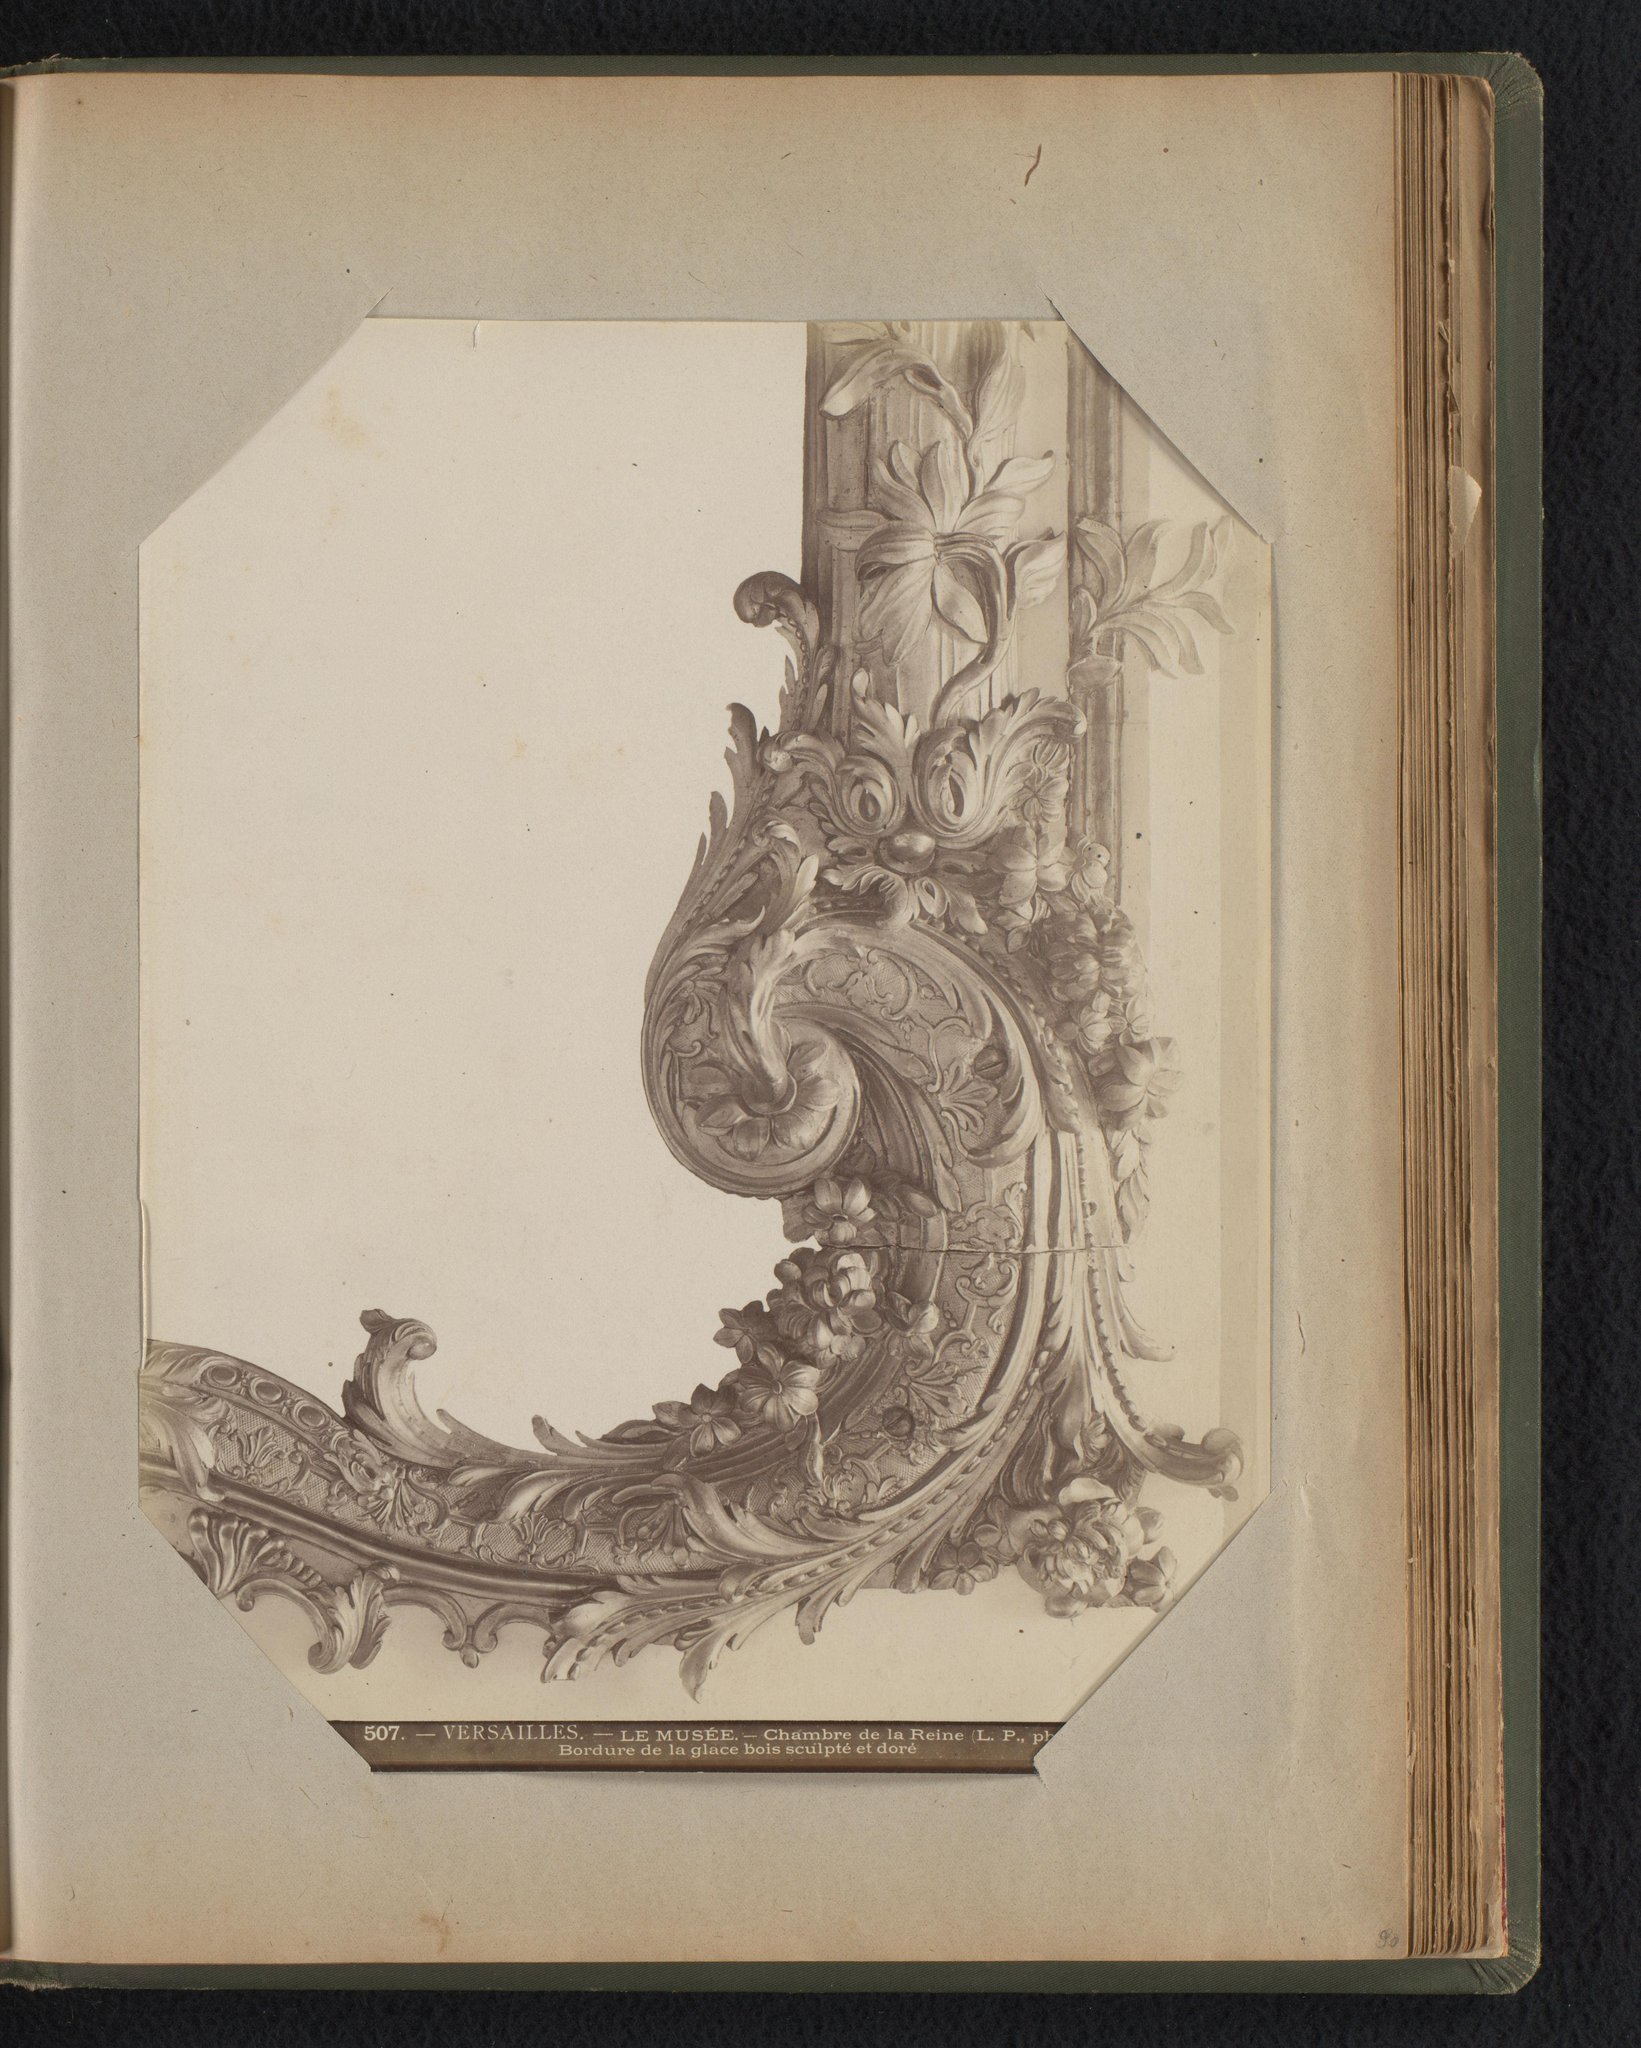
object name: photograph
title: Ornament met houtsnijwerk op een raampost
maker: Anonymous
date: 1860-1900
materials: paper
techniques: albumen print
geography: france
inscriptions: annotation: ‘507 - Versailles Le Musee - Chambre de la Reine (L.P. Phot) Bordure de la glace bois sculpté et doré.’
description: Onderdeel van een serie met betrekking tot het interieur van het paleis van Versailles met kroonluchters, deuren, portalen en meubelstukken.